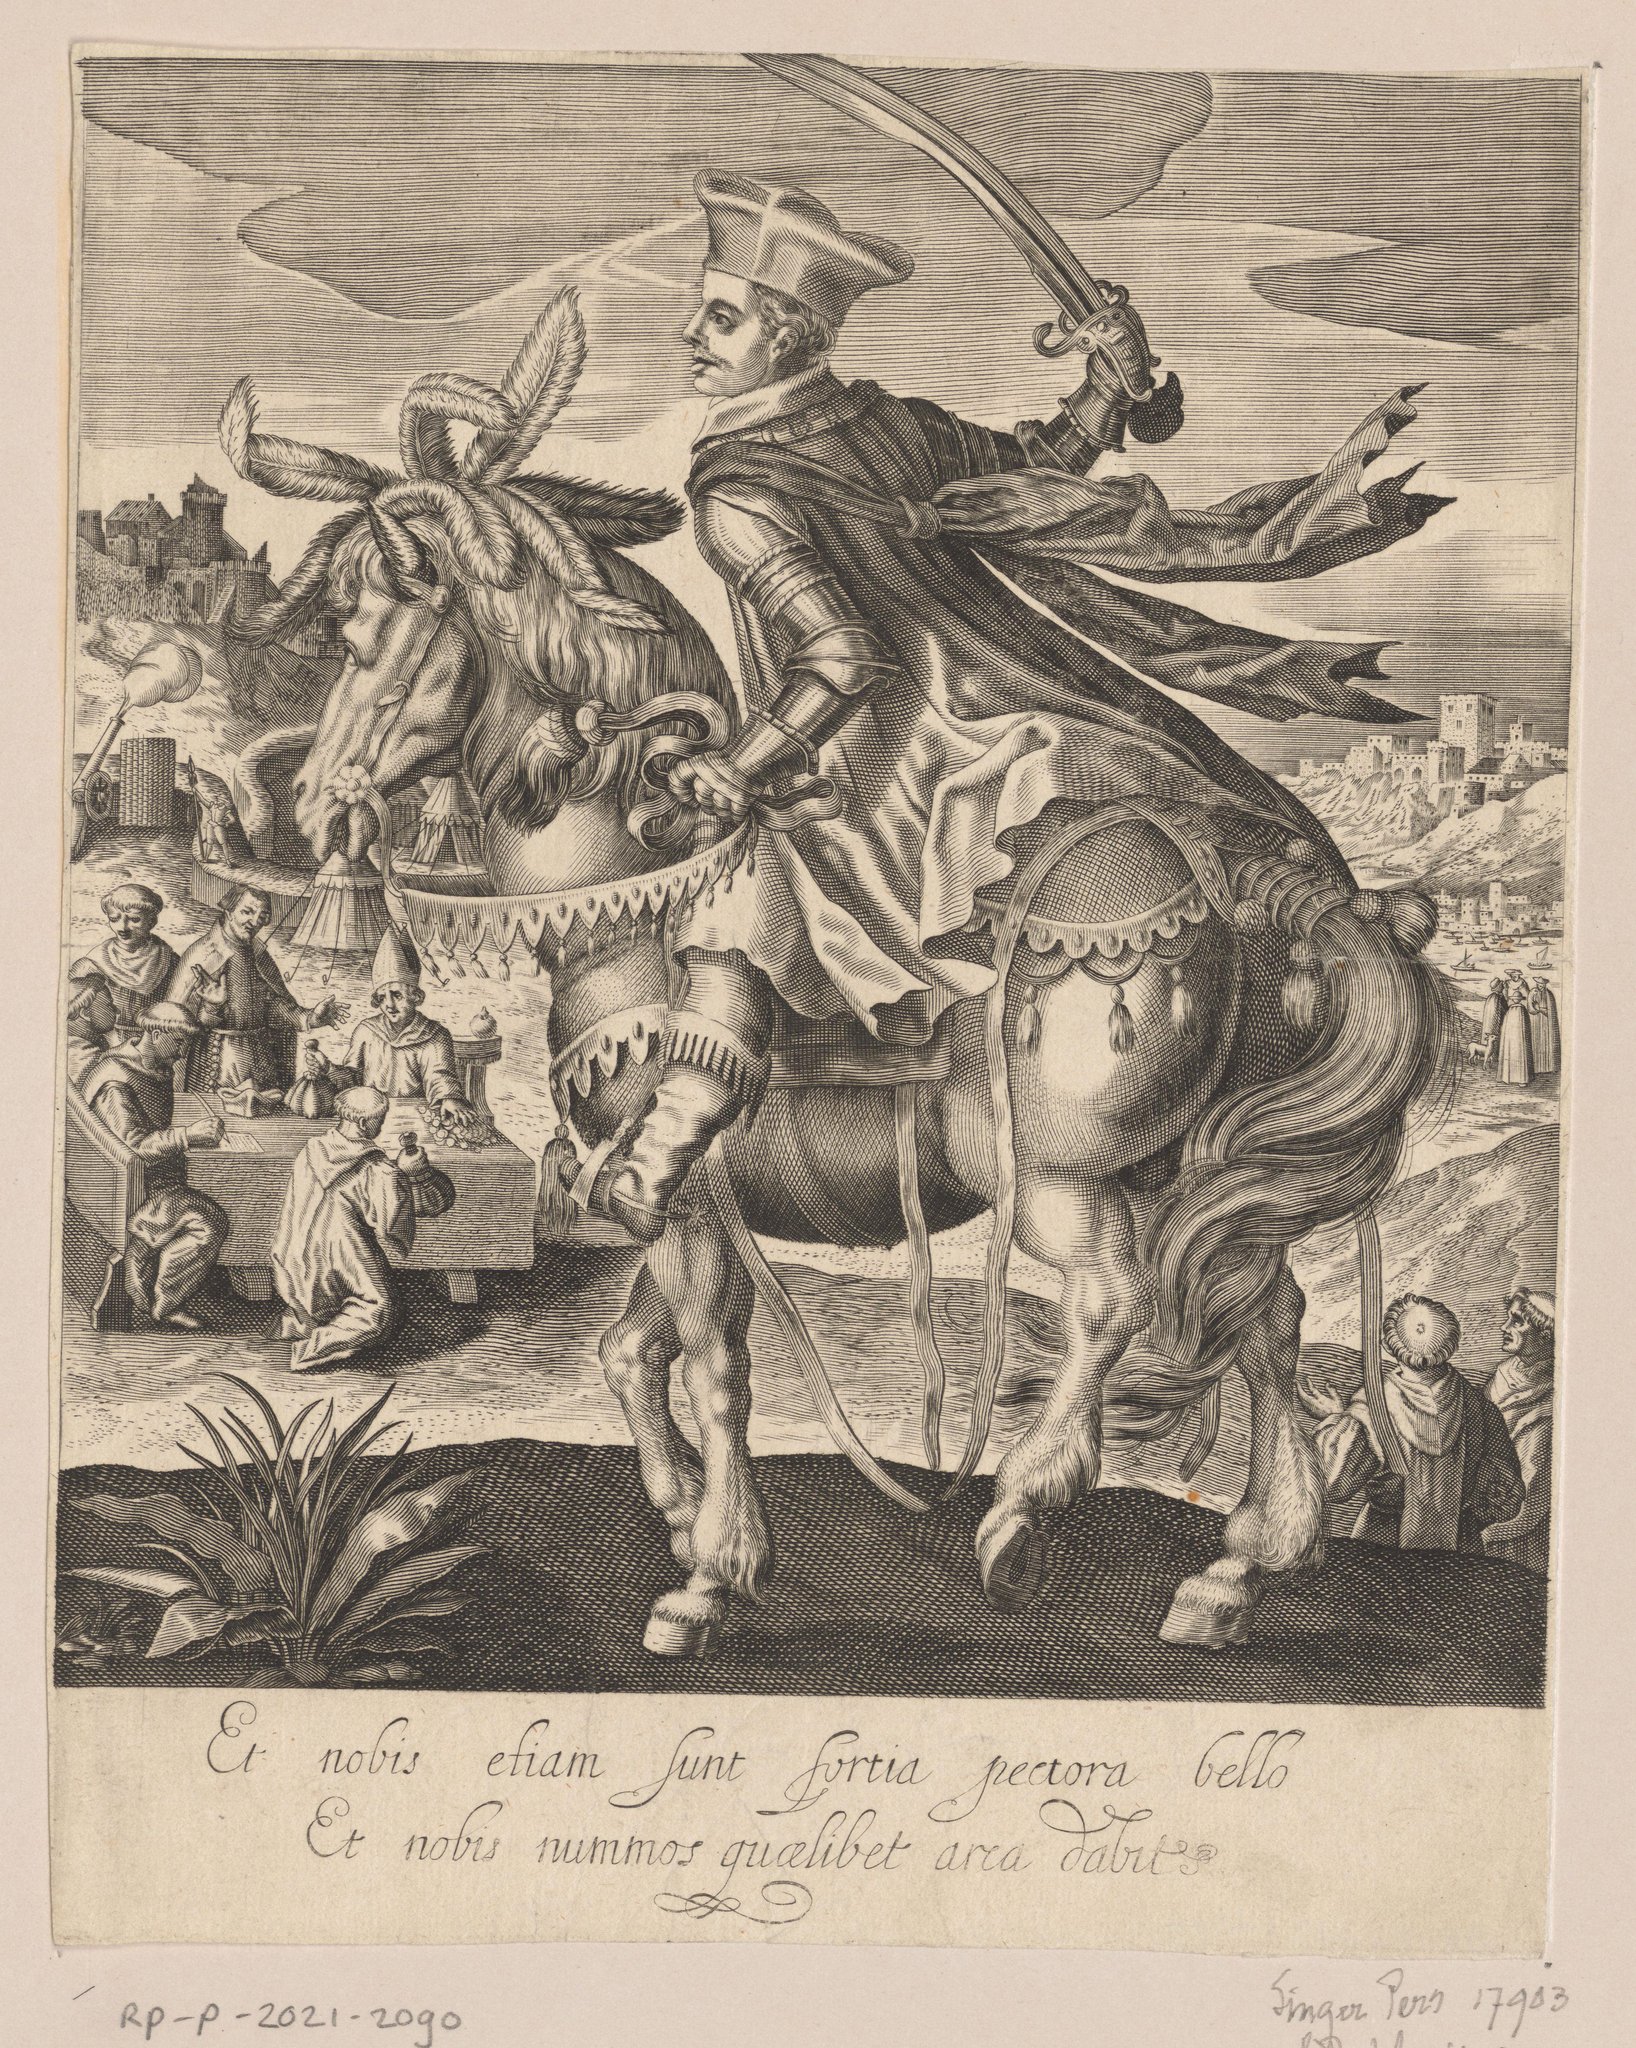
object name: print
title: Ruiterportret van Leopold V, aartshertog van Oostenrijk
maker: Anonymous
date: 1609-1611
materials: paper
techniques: engraving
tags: leopold v (aartshertog van oostenrijk), equestrian state-portrait, archbishop, bishop, etc. (roman catholic), armour, historical persons, monk(s), friar(s), firearms: cannon, money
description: Met tweeregelig onderschrift in het Latijn. Links een bisschop en monniken rondom een tafel waarop munten liggen. Op de achtergrond een legerkamp en twee steden, waarschijnlijk een voorstelling uit de Gulik-Kleefse Successieoorlog.